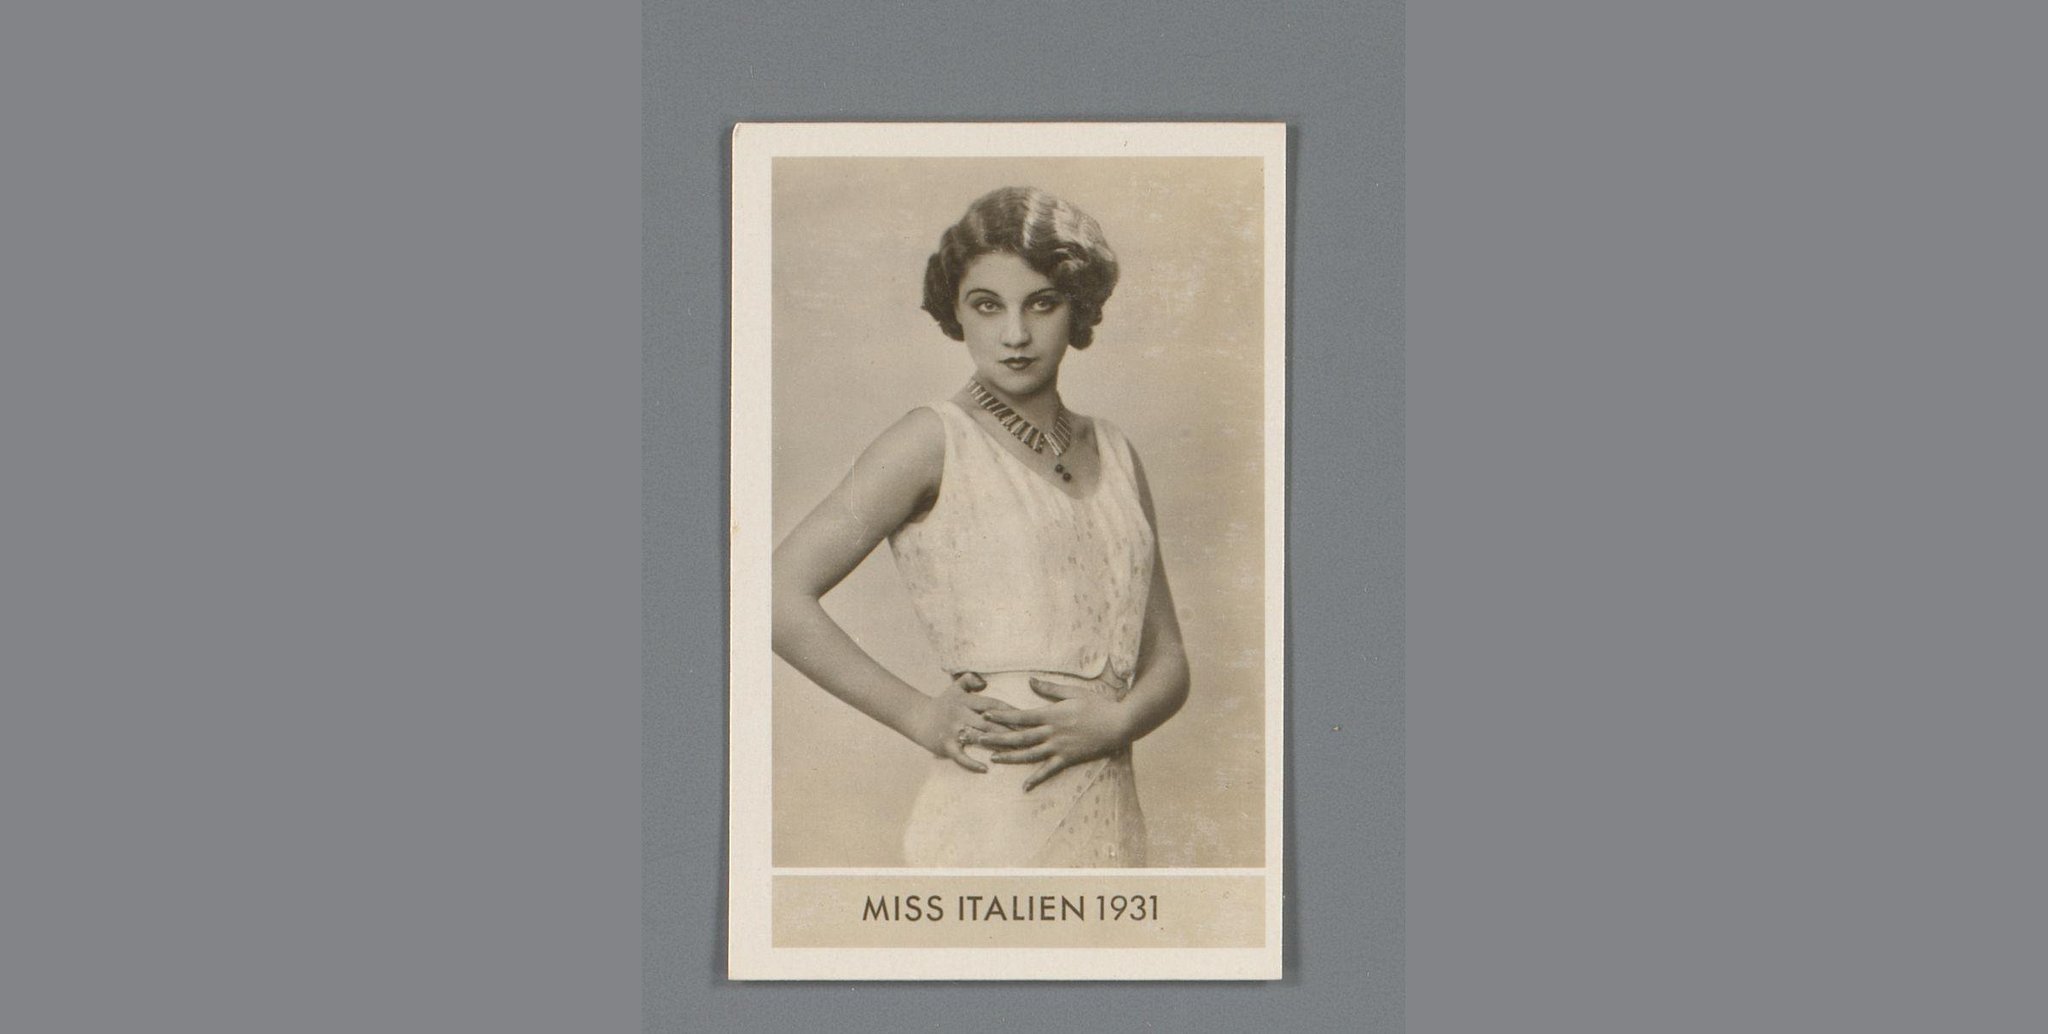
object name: photograph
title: Miss Italien 1931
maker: Anonymous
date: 1931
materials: paper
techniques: gelatin silver print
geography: dresden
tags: historical persons - bb - woman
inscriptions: inscription: ‘Die schönsten/ Frauen der Welt/ dargestellt durch die Schön-/ heitsköniginnen aller Länder,/ finden Sie in 190 echten/ Bromsilber-Fotos, die nur den/ CLUB-und-LIGA-Packun-/ gen beiliegen. Eind prächtiges/ Sammel-Album erhalten Sie/ für 75 Pfennig vom Händler/ oder bei Einsendung von/ 75 Pfennig in Briefmarken/ von der Bilderstelle Lohse,/ Dresden A24, Nossener Str. 1./ Ges. gesch. Nachdruck verboten!’